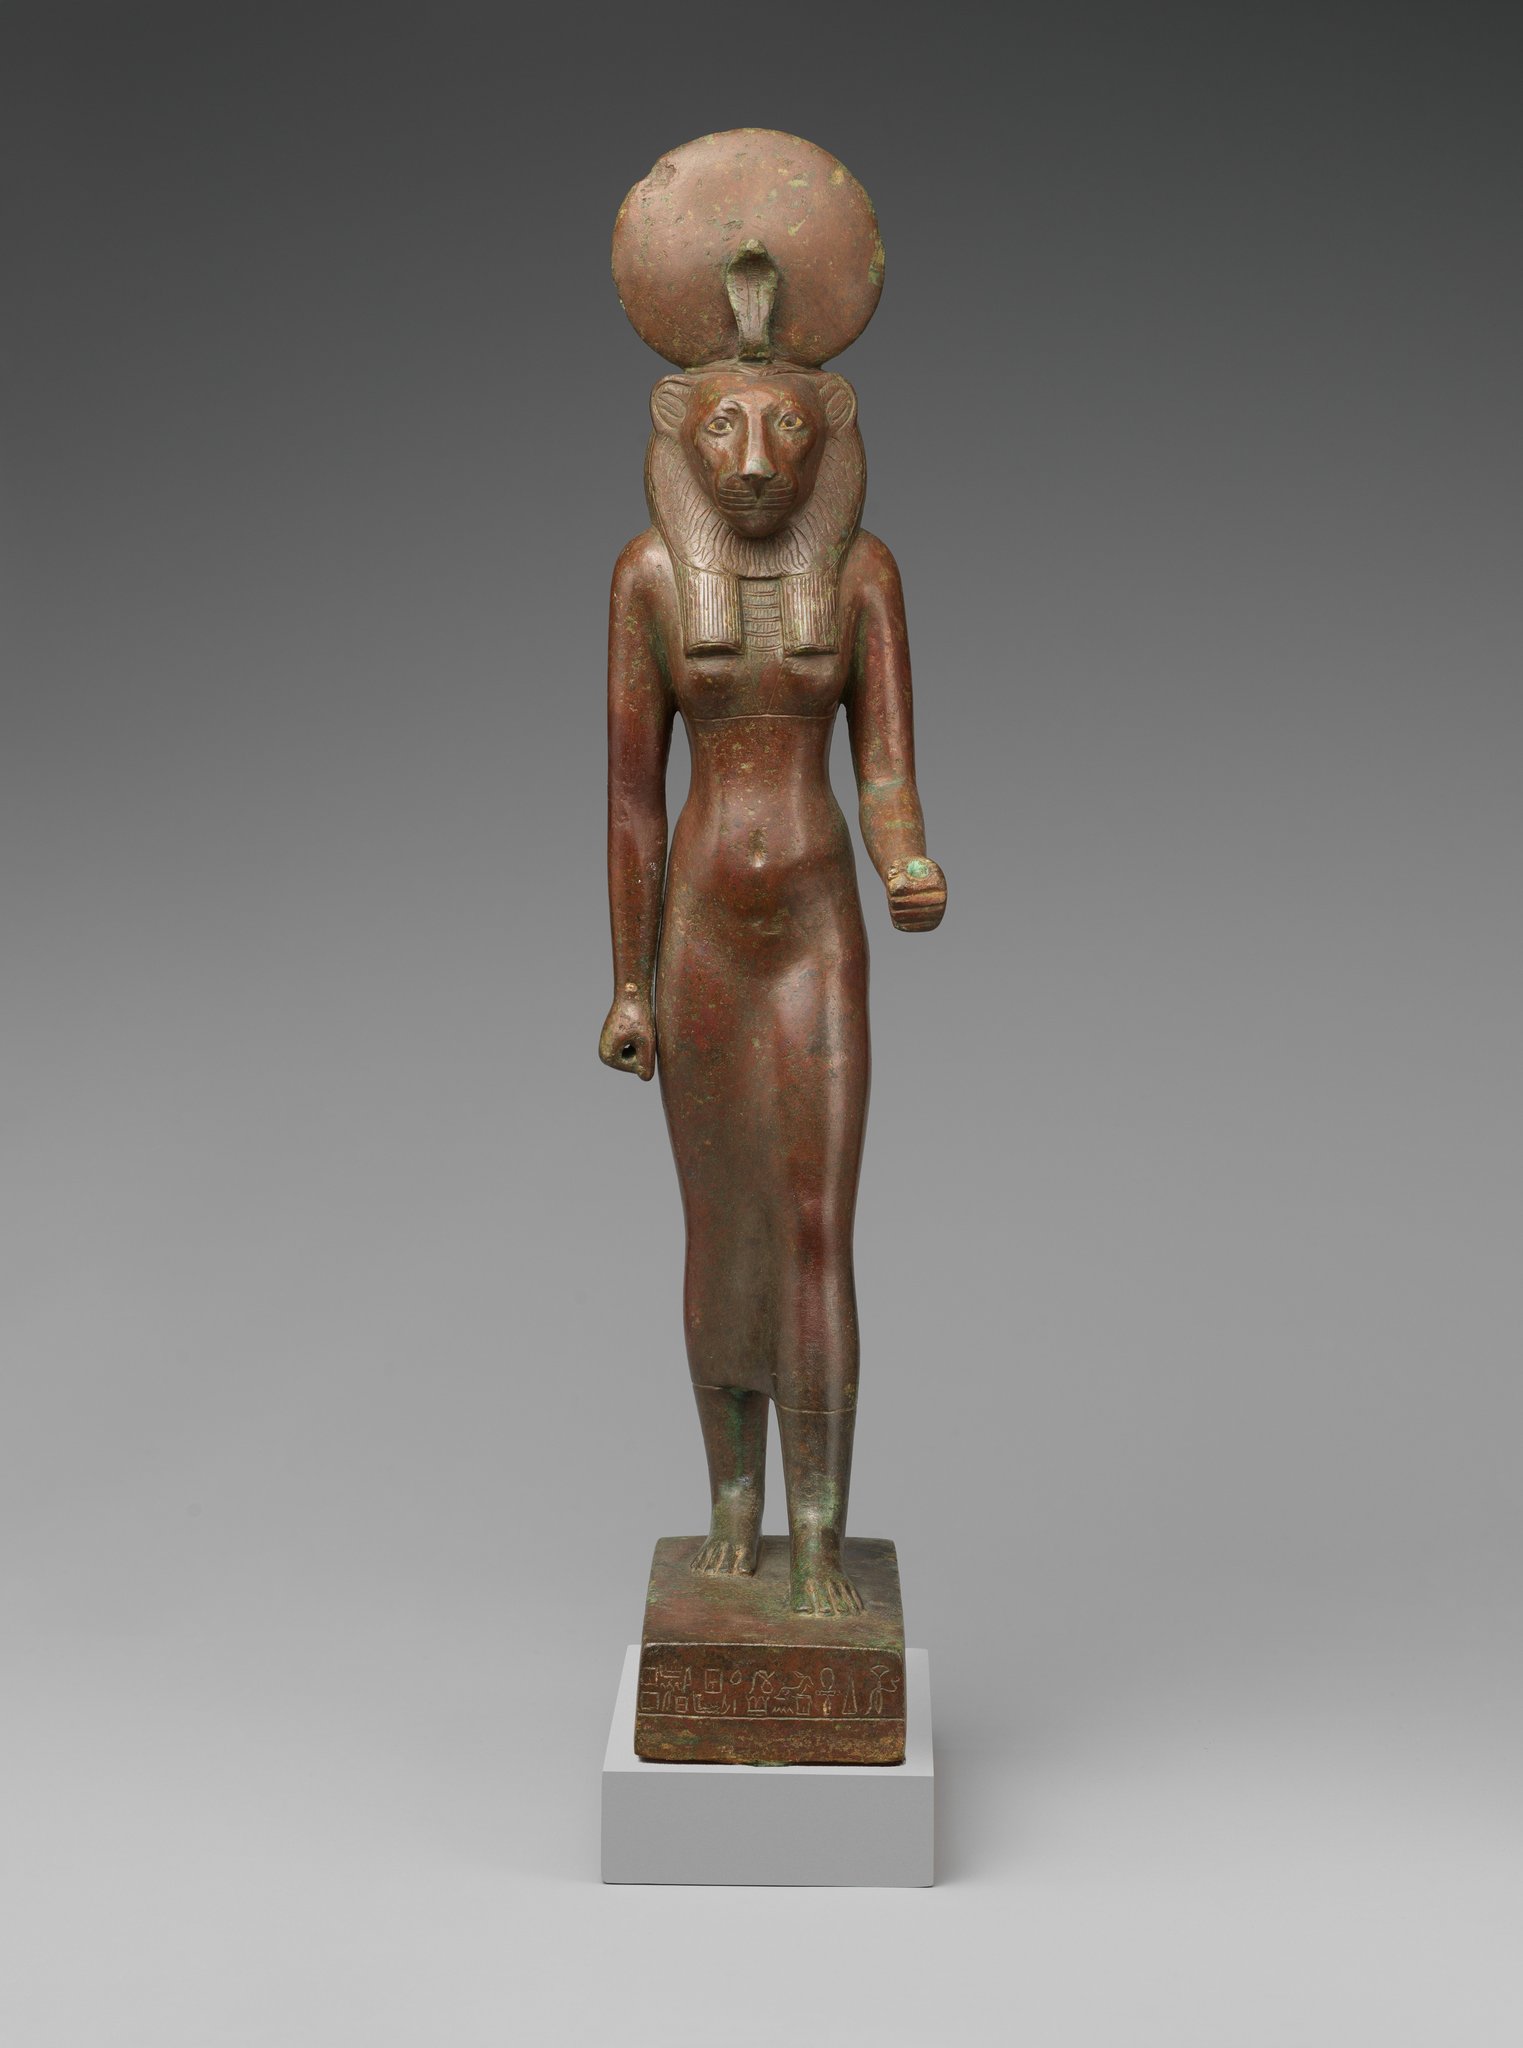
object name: statuette, wadjet, for akanosh, son of pediamenopet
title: Statuette of Wadjet dedicated by Akanosh son of Pediamenopet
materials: metal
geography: egypt